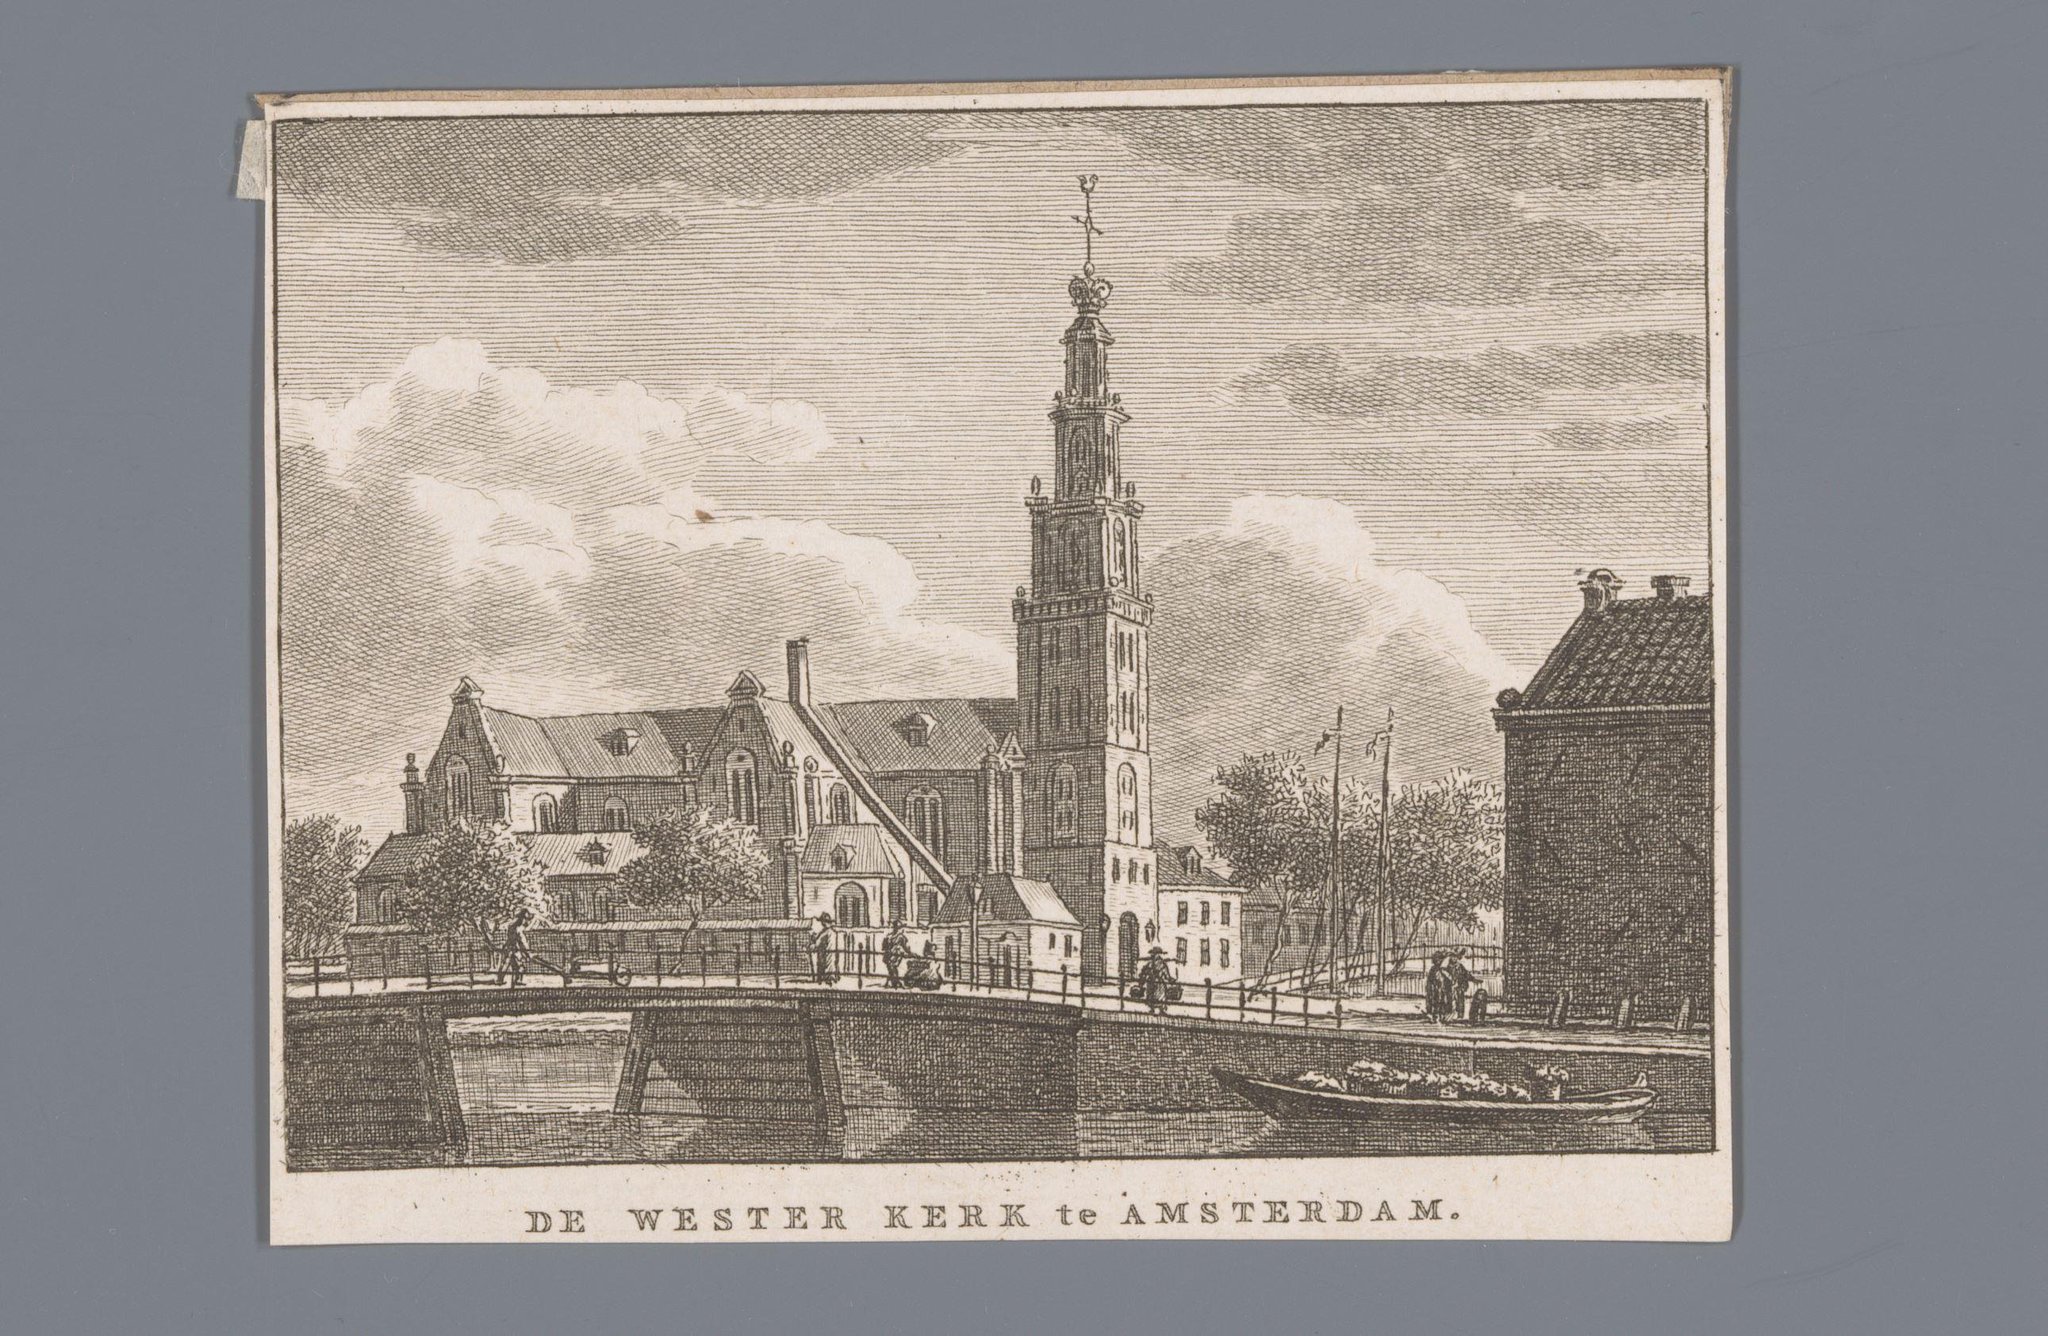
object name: print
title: Gezicht op de Westerkerk te Amsterdam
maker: carel frederik bendorp (i)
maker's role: print maker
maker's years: 1736-1814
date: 1786-1792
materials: paper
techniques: etching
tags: protestant churches and denominations, bridge in city across river, canal, etc.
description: Prent uit: Vaderlandsche gezichten, of afbeeldingen van den tegenwoordigen staat der Vereenigde Nederlanden (…). Amsterdam: Hendrik Gartman, Willem Vermandel en Jan Willem Smit, 1786-1792. Uitgegeven in afleveringen met ieder een eigen bifolium en inhoudsopgave. Alle prenten in deze publicatie zijn gegraveerd door Carel Frederik Bendorp (I) en, in de meeste gevallen, gebaseerd op tekeningen van Jan Bulthuis. Afgesneden van blad met een afbeelding van de Oude Kerk, zie RP-P-1911-2938.